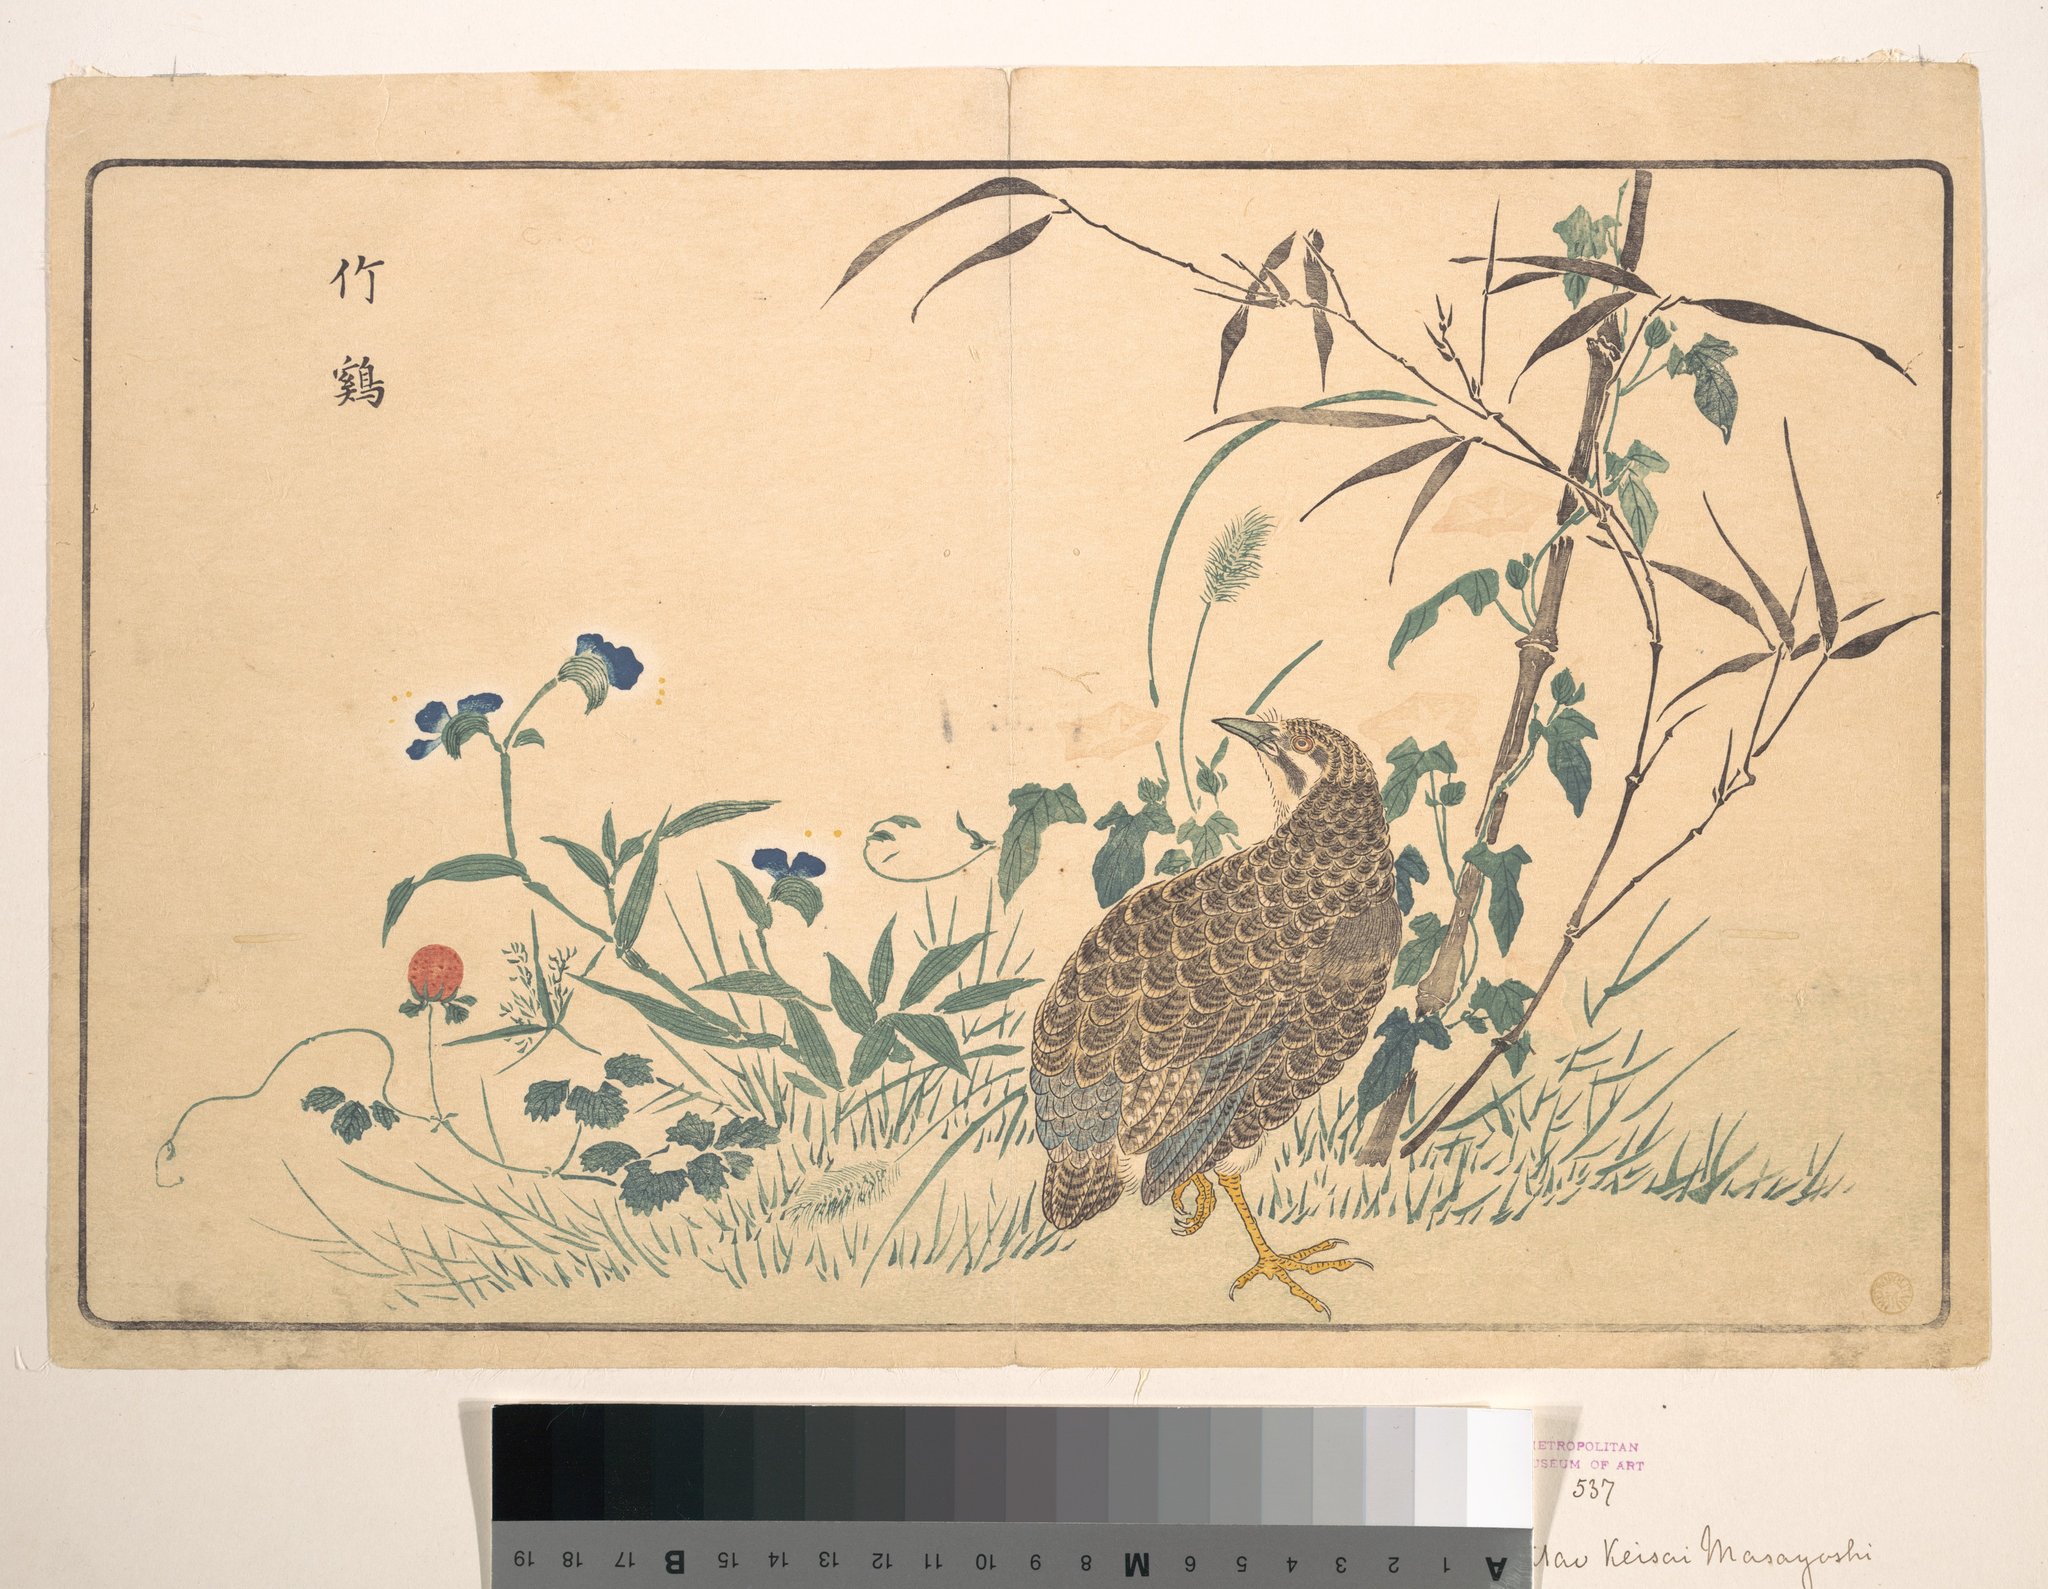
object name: print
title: Zhu ji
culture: japanese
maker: kuwagata keisai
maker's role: artist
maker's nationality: japanese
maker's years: 1764-1824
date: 1789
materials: ink, paper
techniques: woodblock print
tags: pheasants,plants